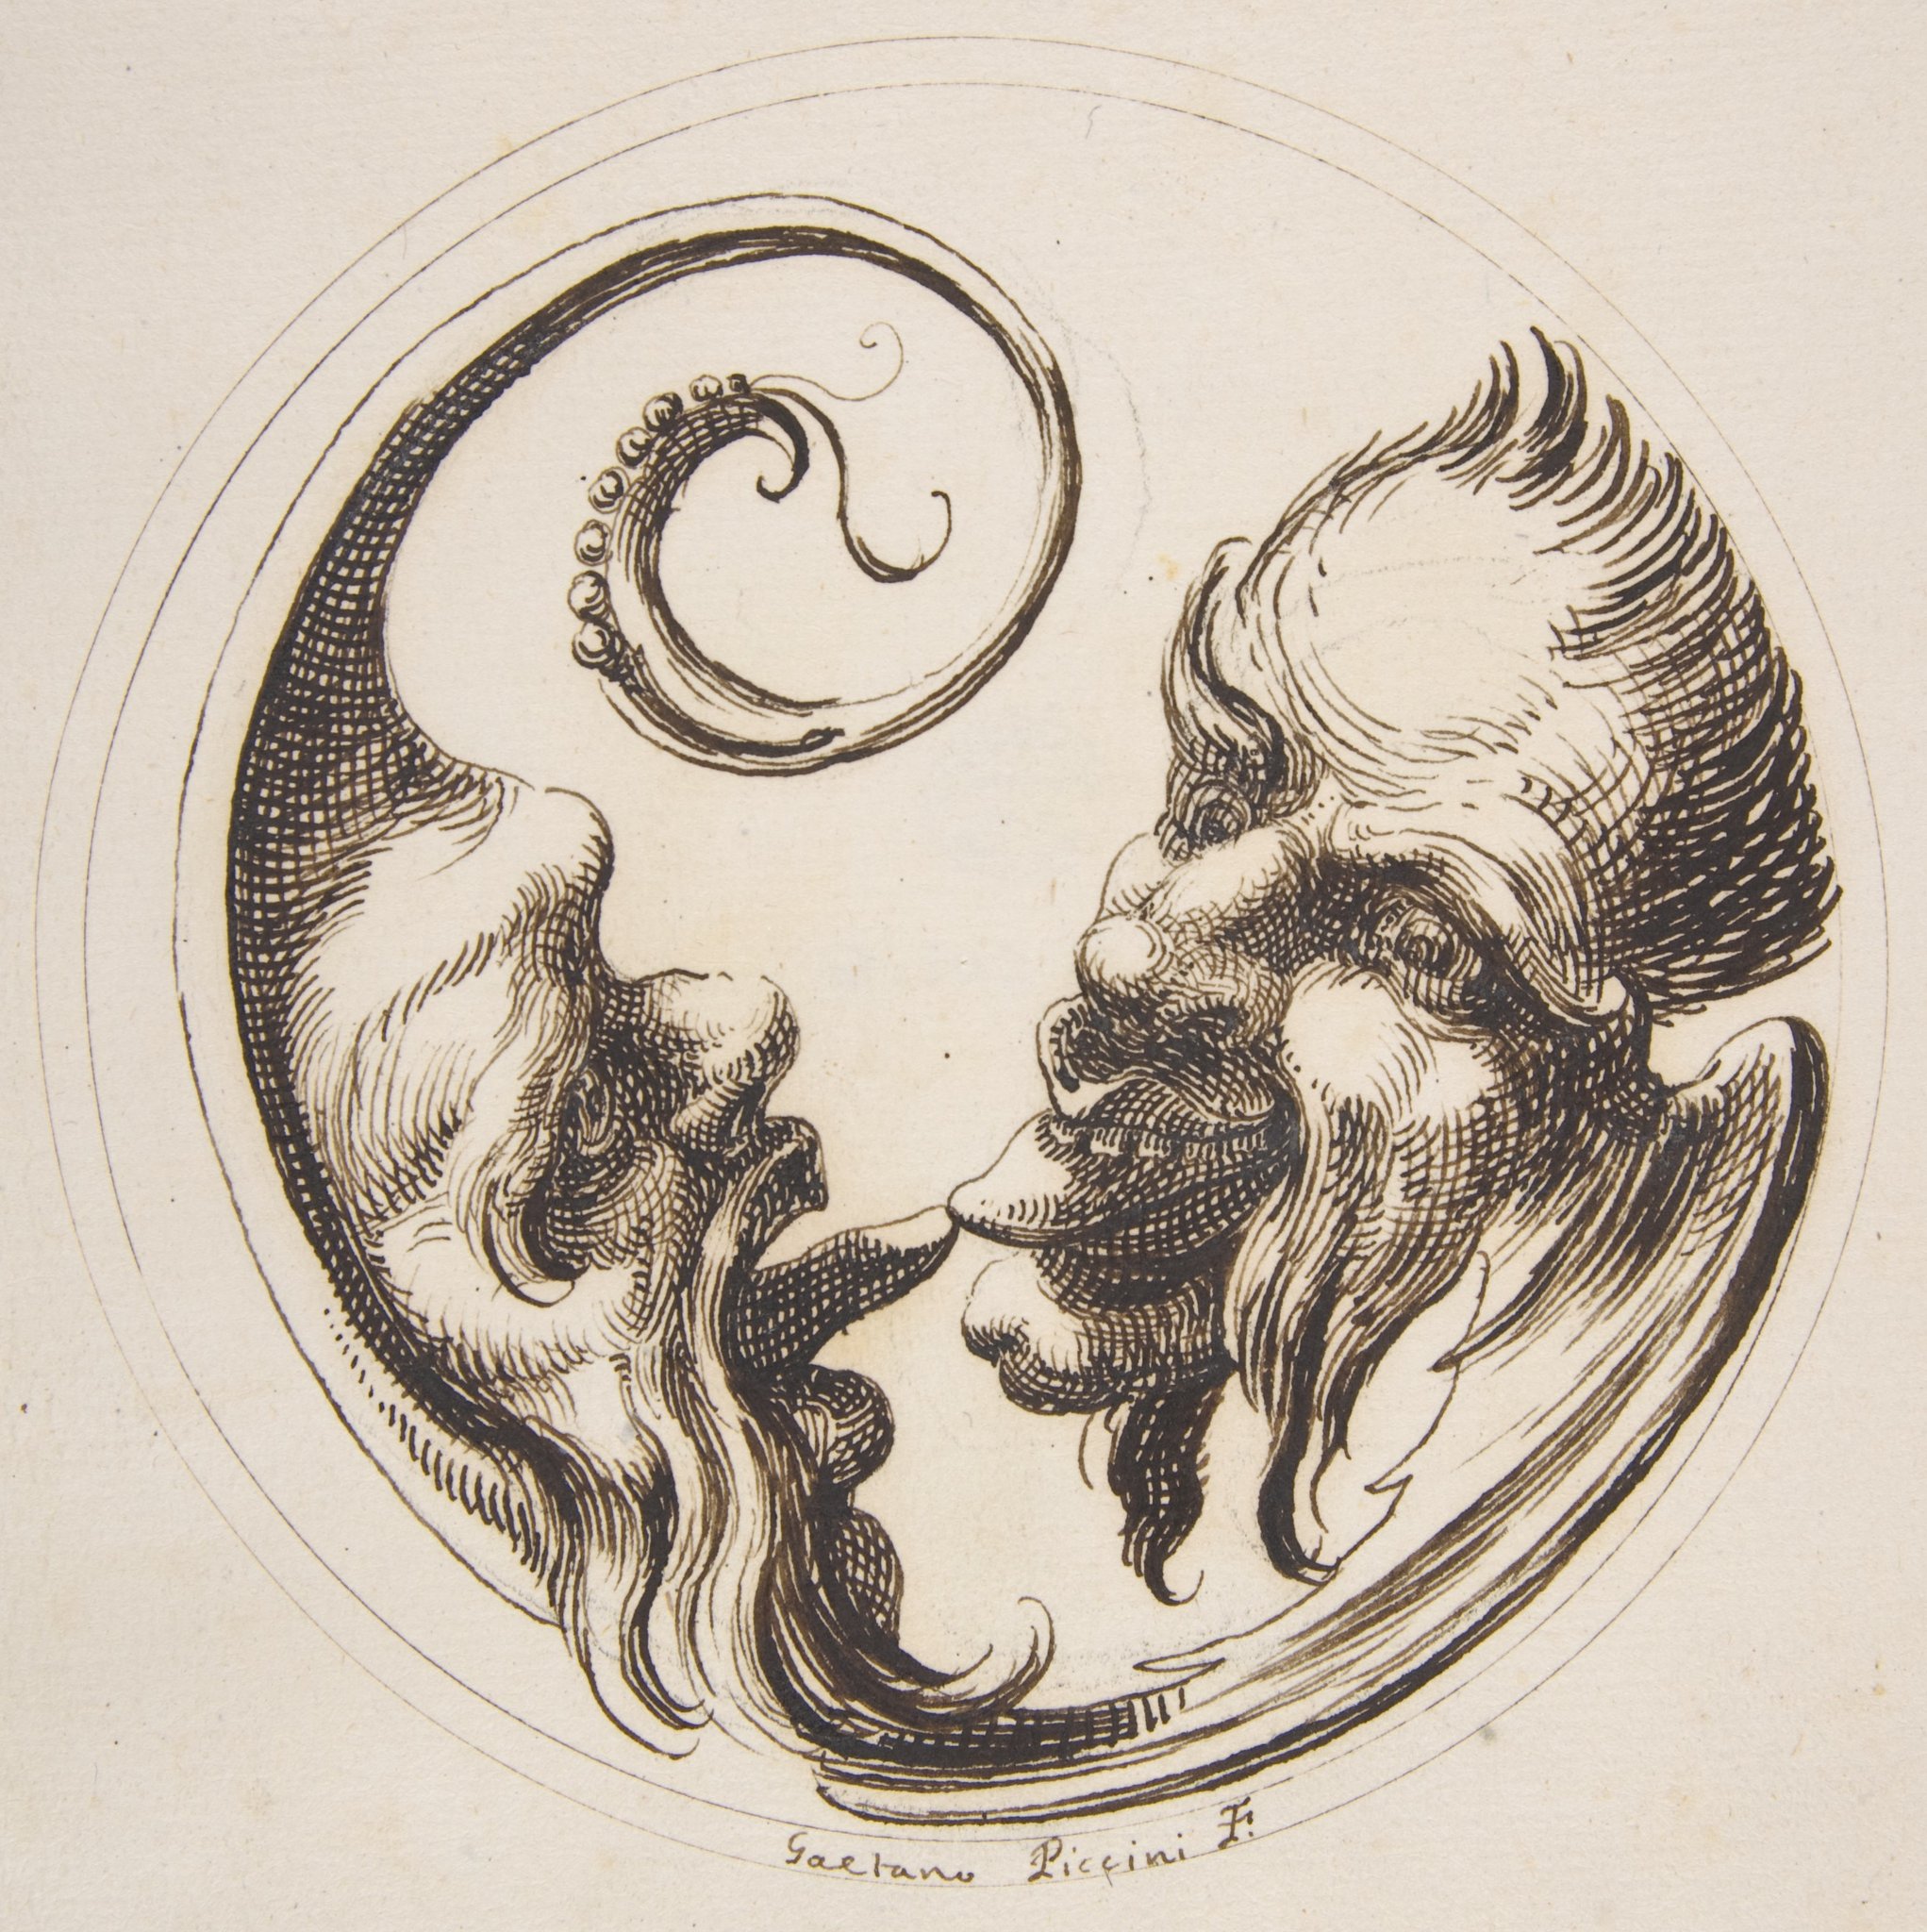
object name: drawing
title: Two Grotesque Heads Facing One Another and Touching Tongues Within a Circle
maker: gaetano piccini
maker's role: artist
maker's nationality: italian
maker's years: 1710-1730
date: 1727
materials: ink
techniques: pen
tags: heads